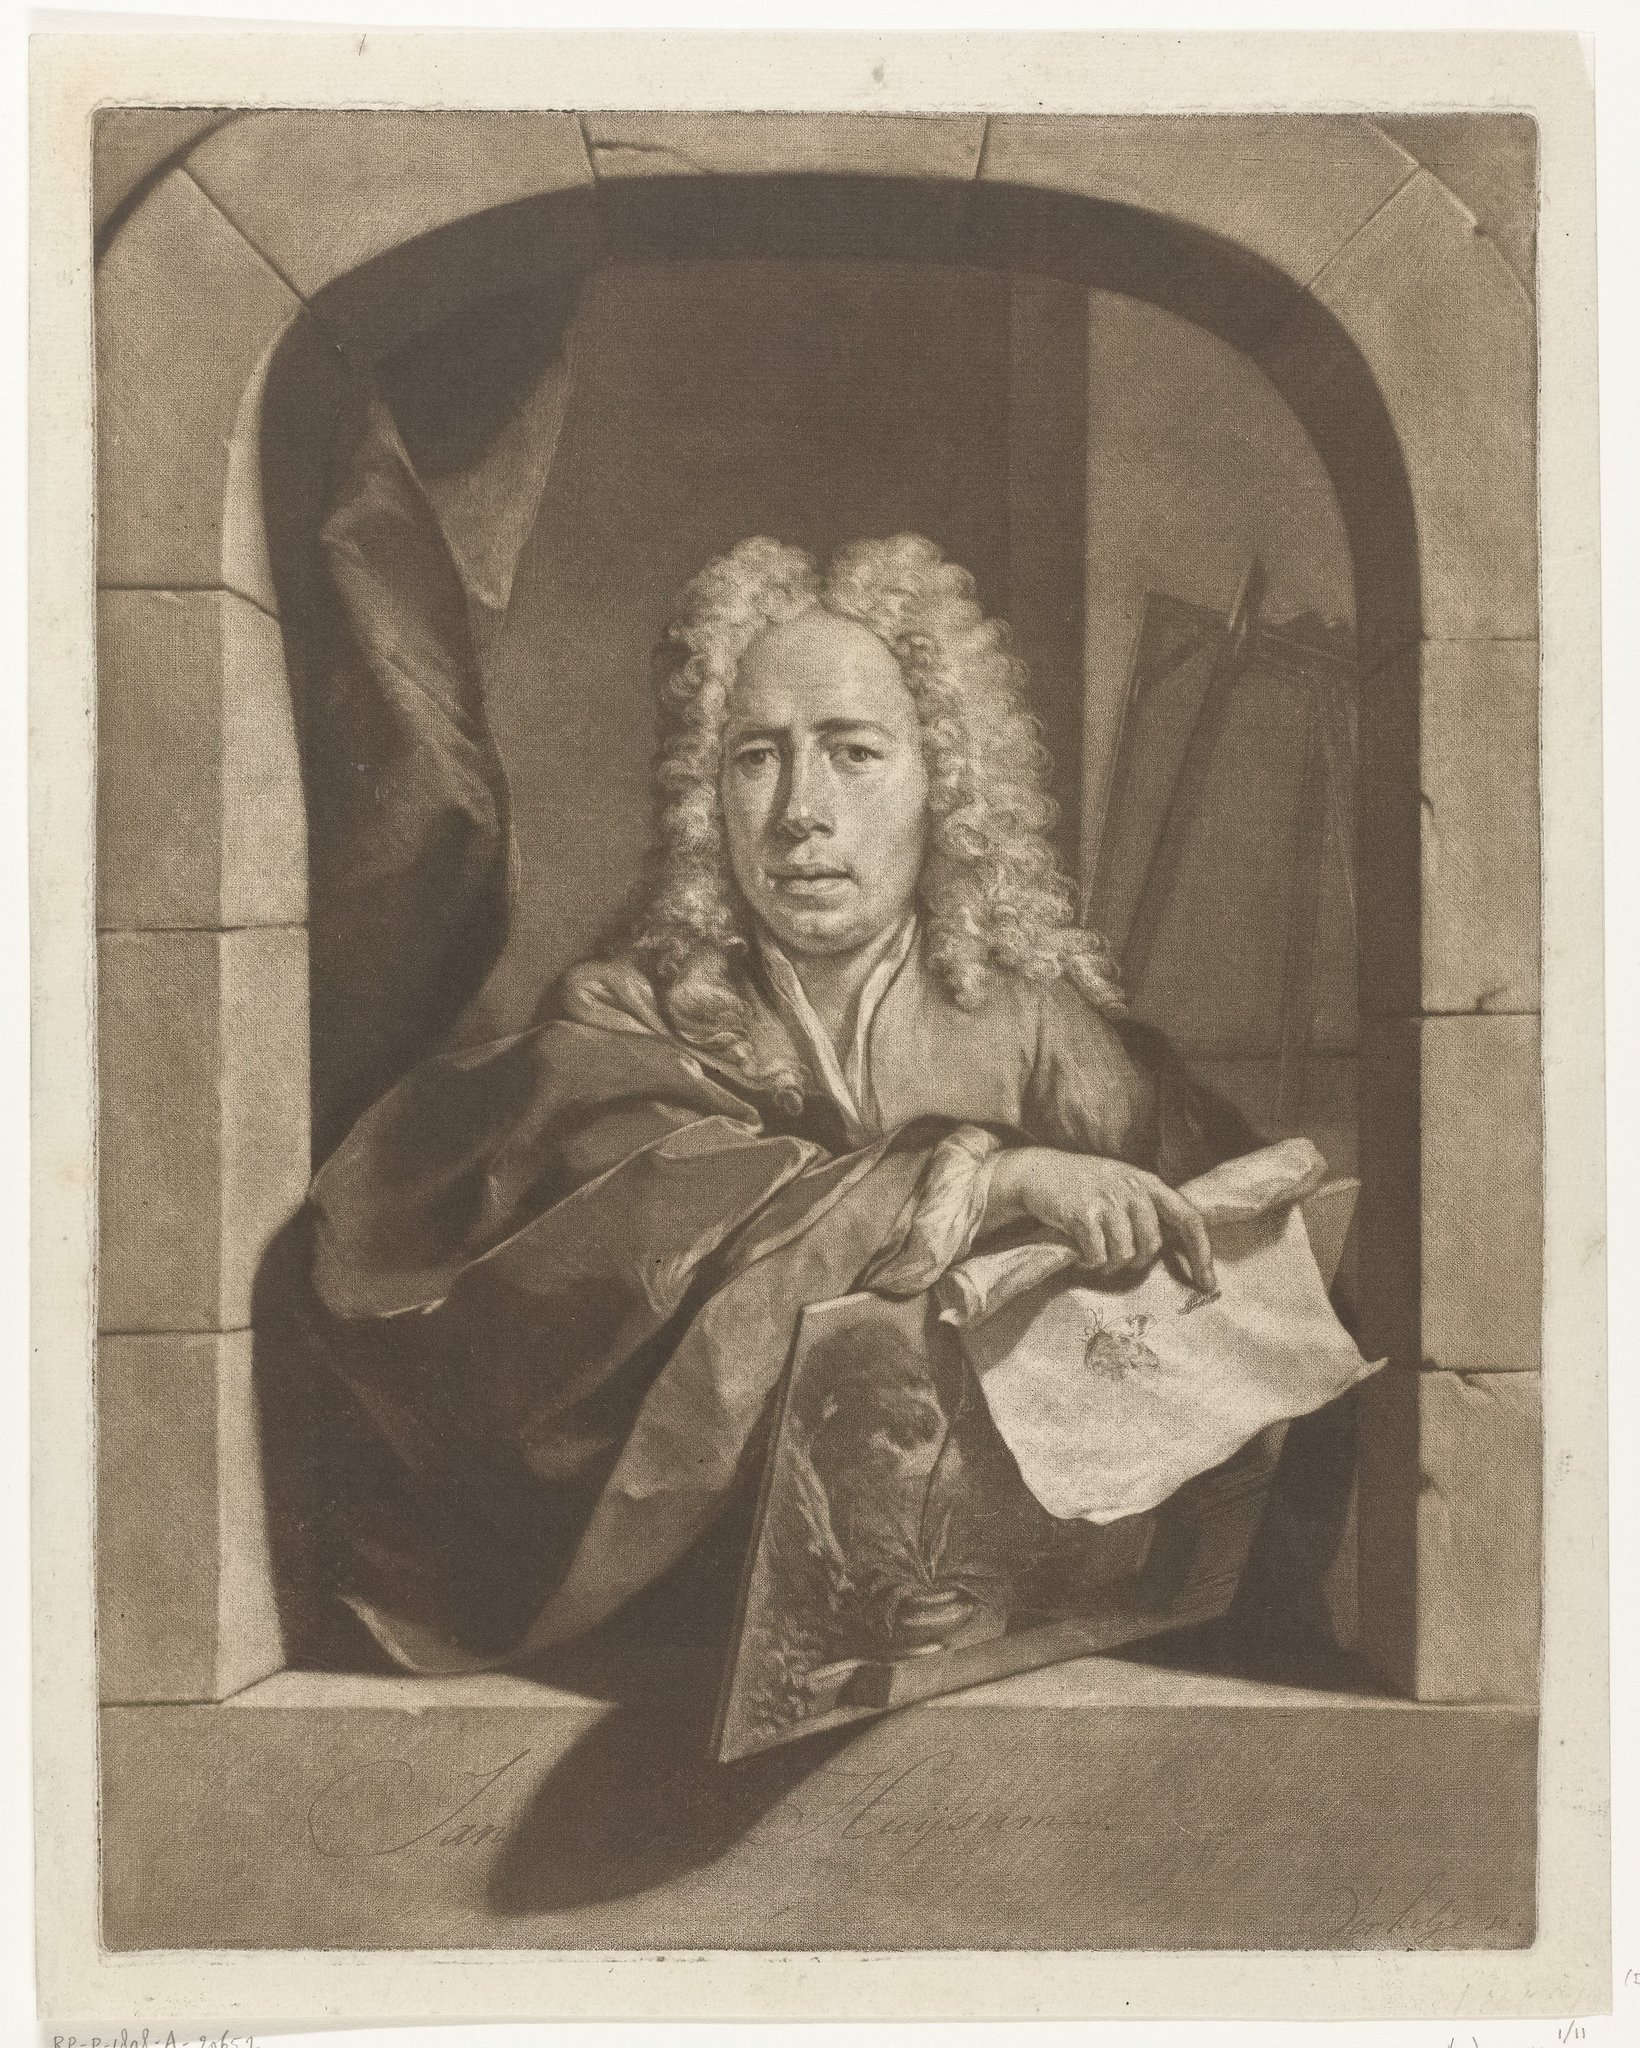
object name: print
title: Portret van Carel Borchaert Voet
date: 1700-1746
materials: paper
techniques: mezzotint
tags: dordrecht, draughtsman, carel borchaert voet, drawing, portrait, self-portrait of painter, easel, picture, painting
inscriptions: collector's mark: Lugt 270, collector's mark: Lugt 964, collector's mark: Lugt 2228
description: De stillevenschilder Carel Borchaert Voet staat in een venster. In zijn hand heeft hij een paneel, waarop diverse planten, en een rol papier, waarop twee insecten zijn afgebeeld. Op de achtergrond en schildersezel.